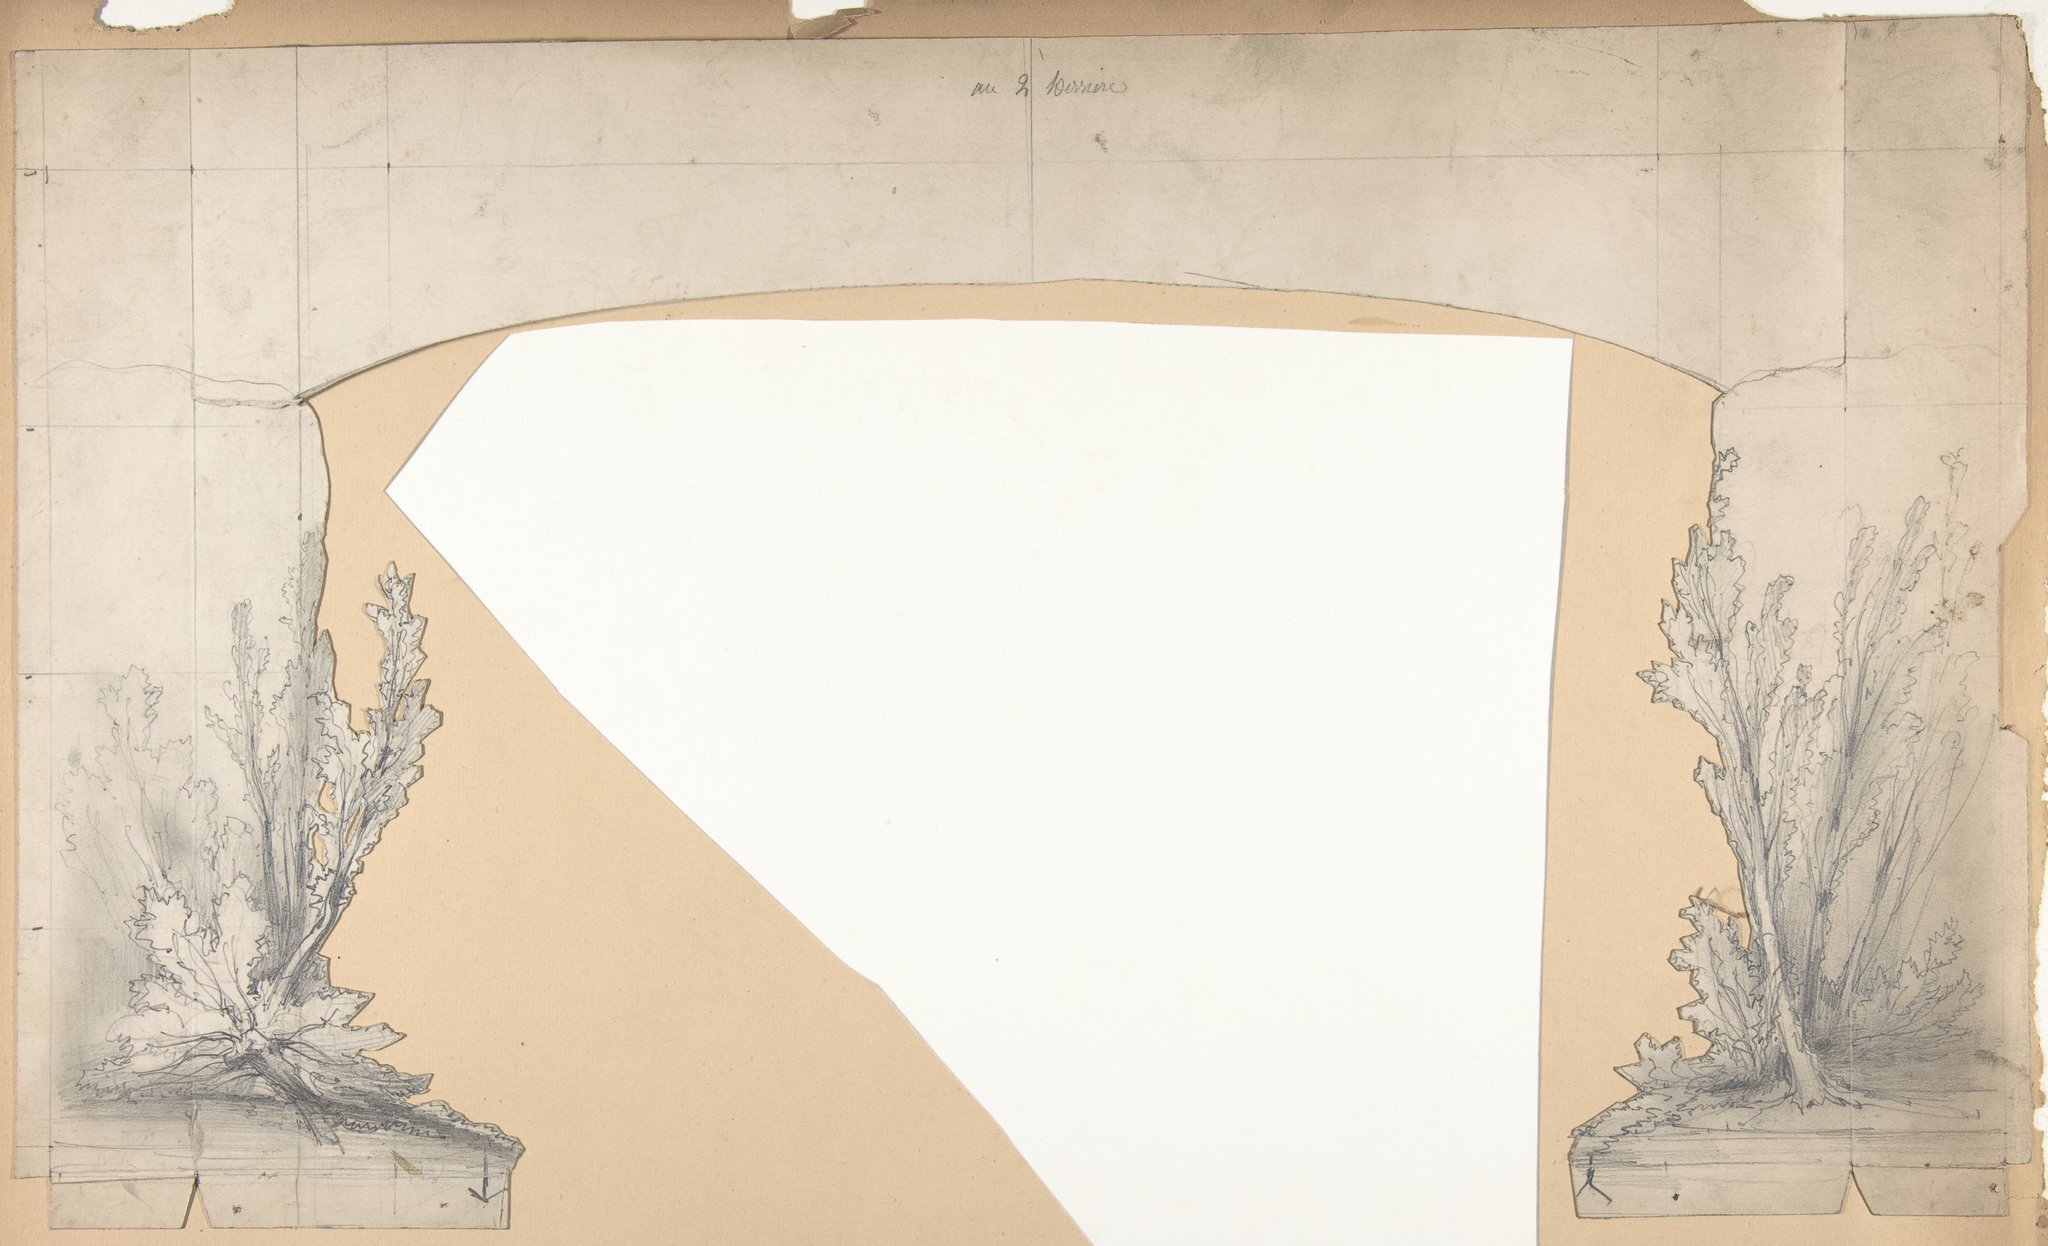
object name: drawing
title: Design for a Stage Set at the Opéra, Paris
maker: eugène cicéri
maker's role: artist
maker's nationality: french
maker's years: 1813-1890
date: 1830-1890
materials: graphite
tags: stage design